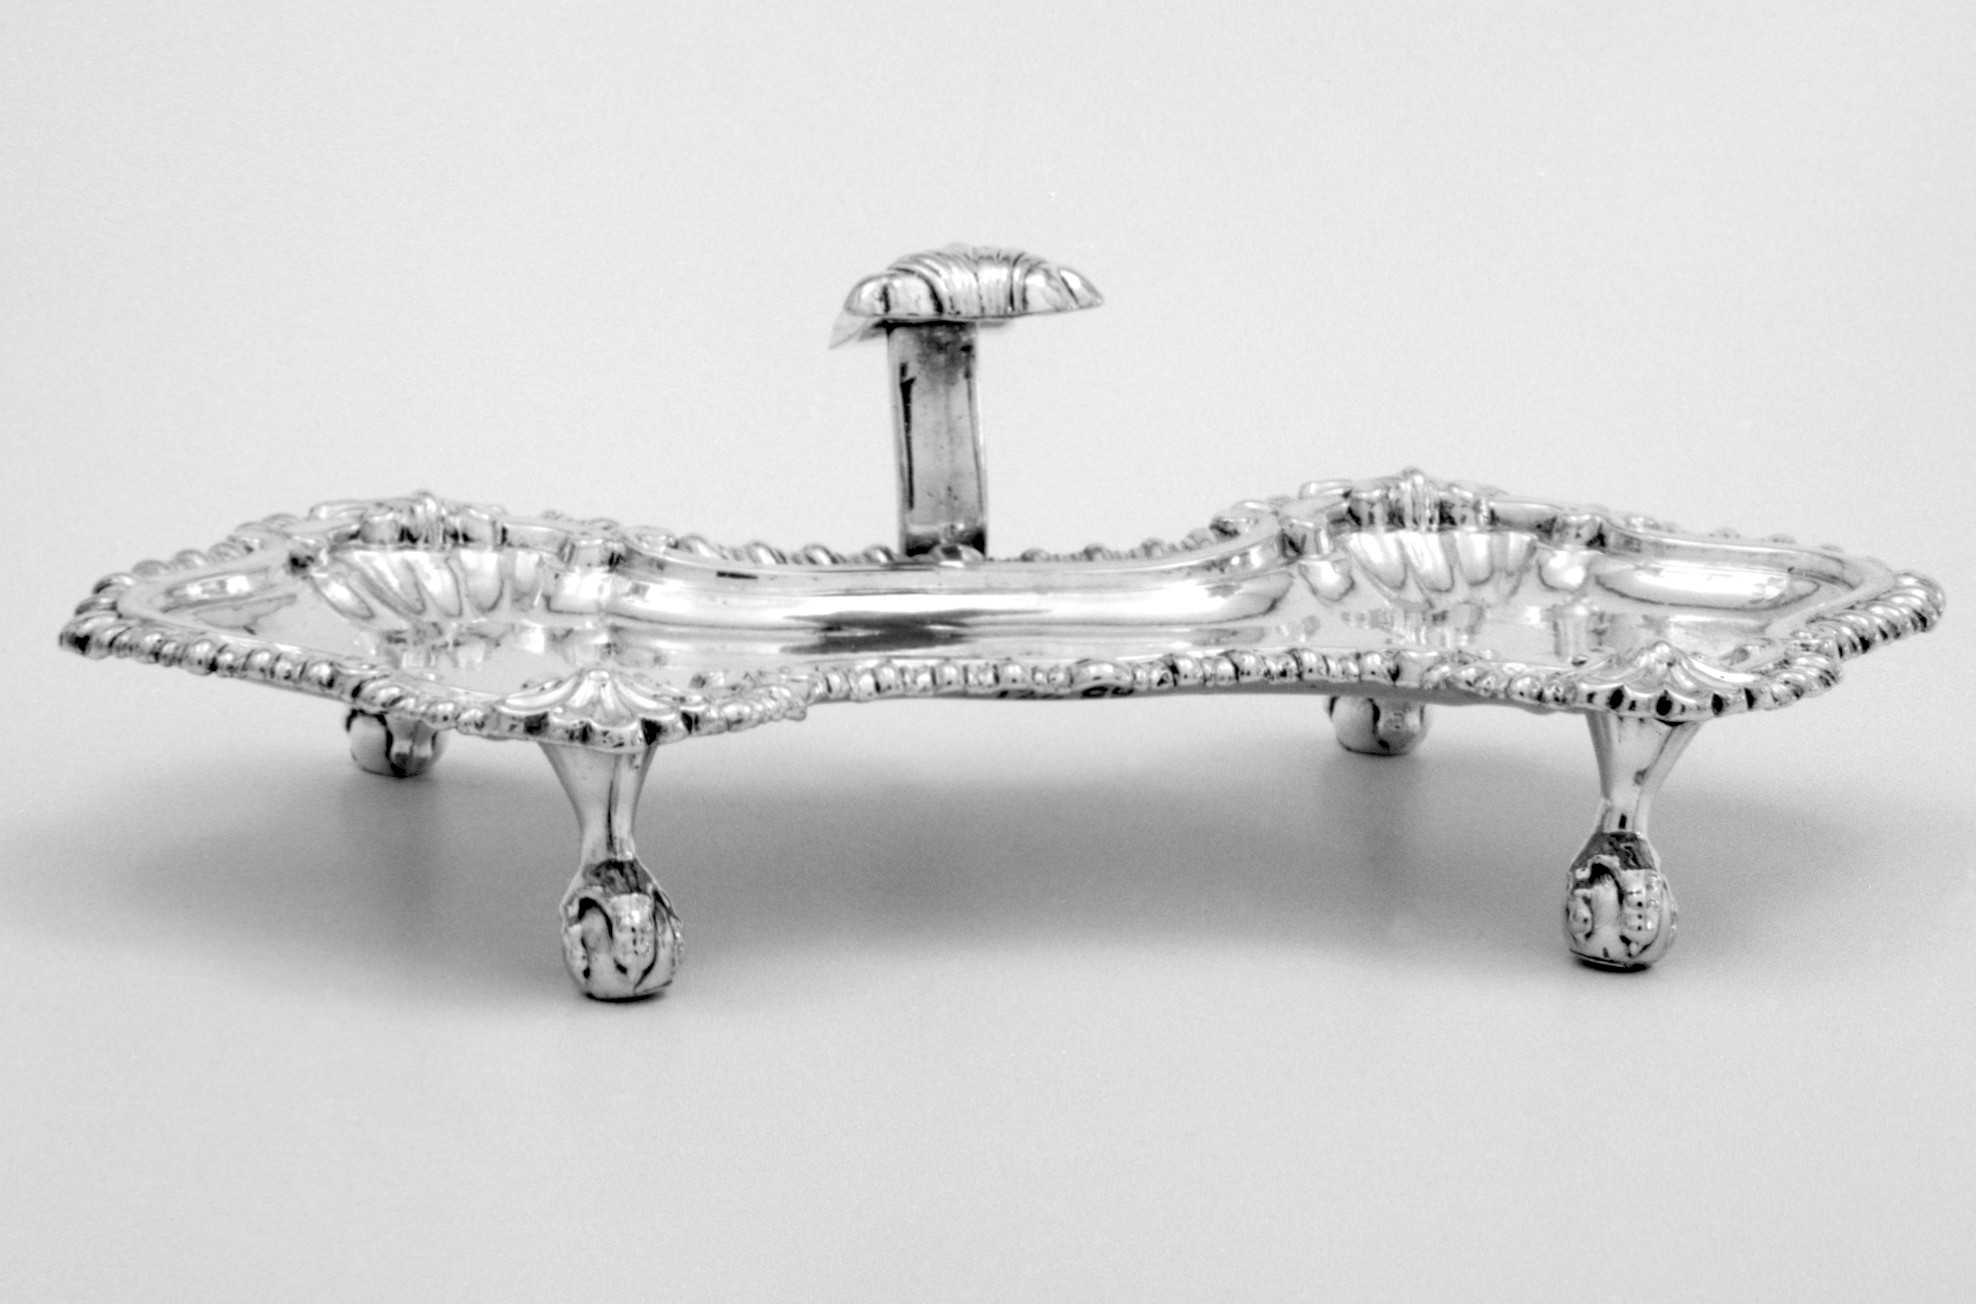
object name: snuffer tray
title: Snuffers tray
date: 1755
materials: silver